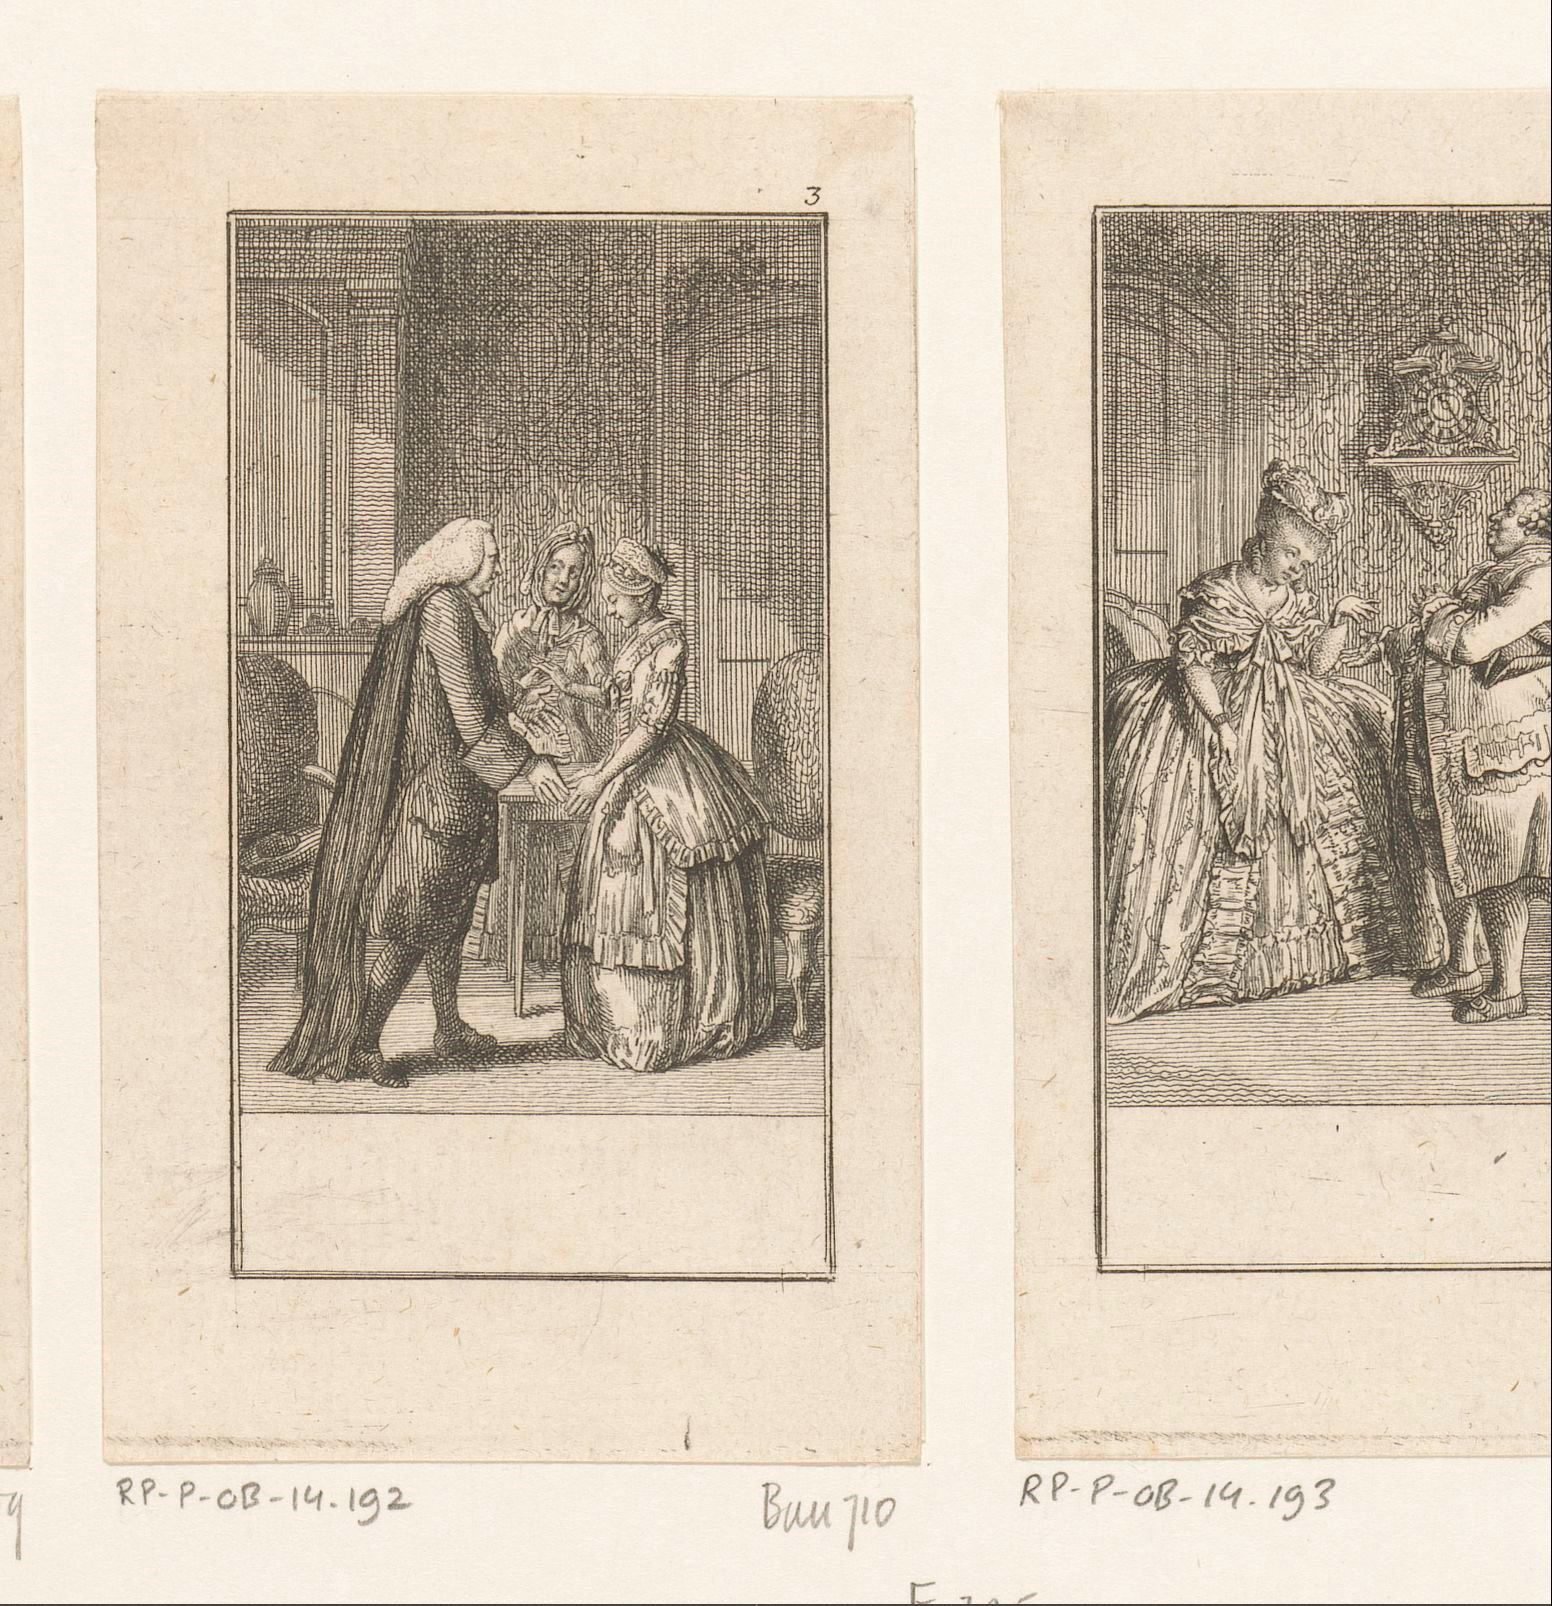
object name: print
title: Huwelijksaanzoek van een predikant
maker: daniel nikolaus chodowiecki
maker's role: draughtsman, print maker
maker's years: 1726-1801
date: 1780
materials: paper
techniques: etching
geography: berlin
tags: functionaries and dignitaries ~ episcopal protestant churches, proposal, declaration of love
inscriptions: collector's mark: Lugt 2228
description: Derde prent afkomstig uit een serie van twaalf huwelijksaanzoeken (eerste serie). De scènes zijn op een plaat geëtst. Een latere staat van deze serie is ook gebruikt in: Almanac de Goettingue pour l'année 1781. Mit Erklärung der 12 Blätter von Georg Christoph Lichtenberg. Göttingen: Johann Christian Dieterich.